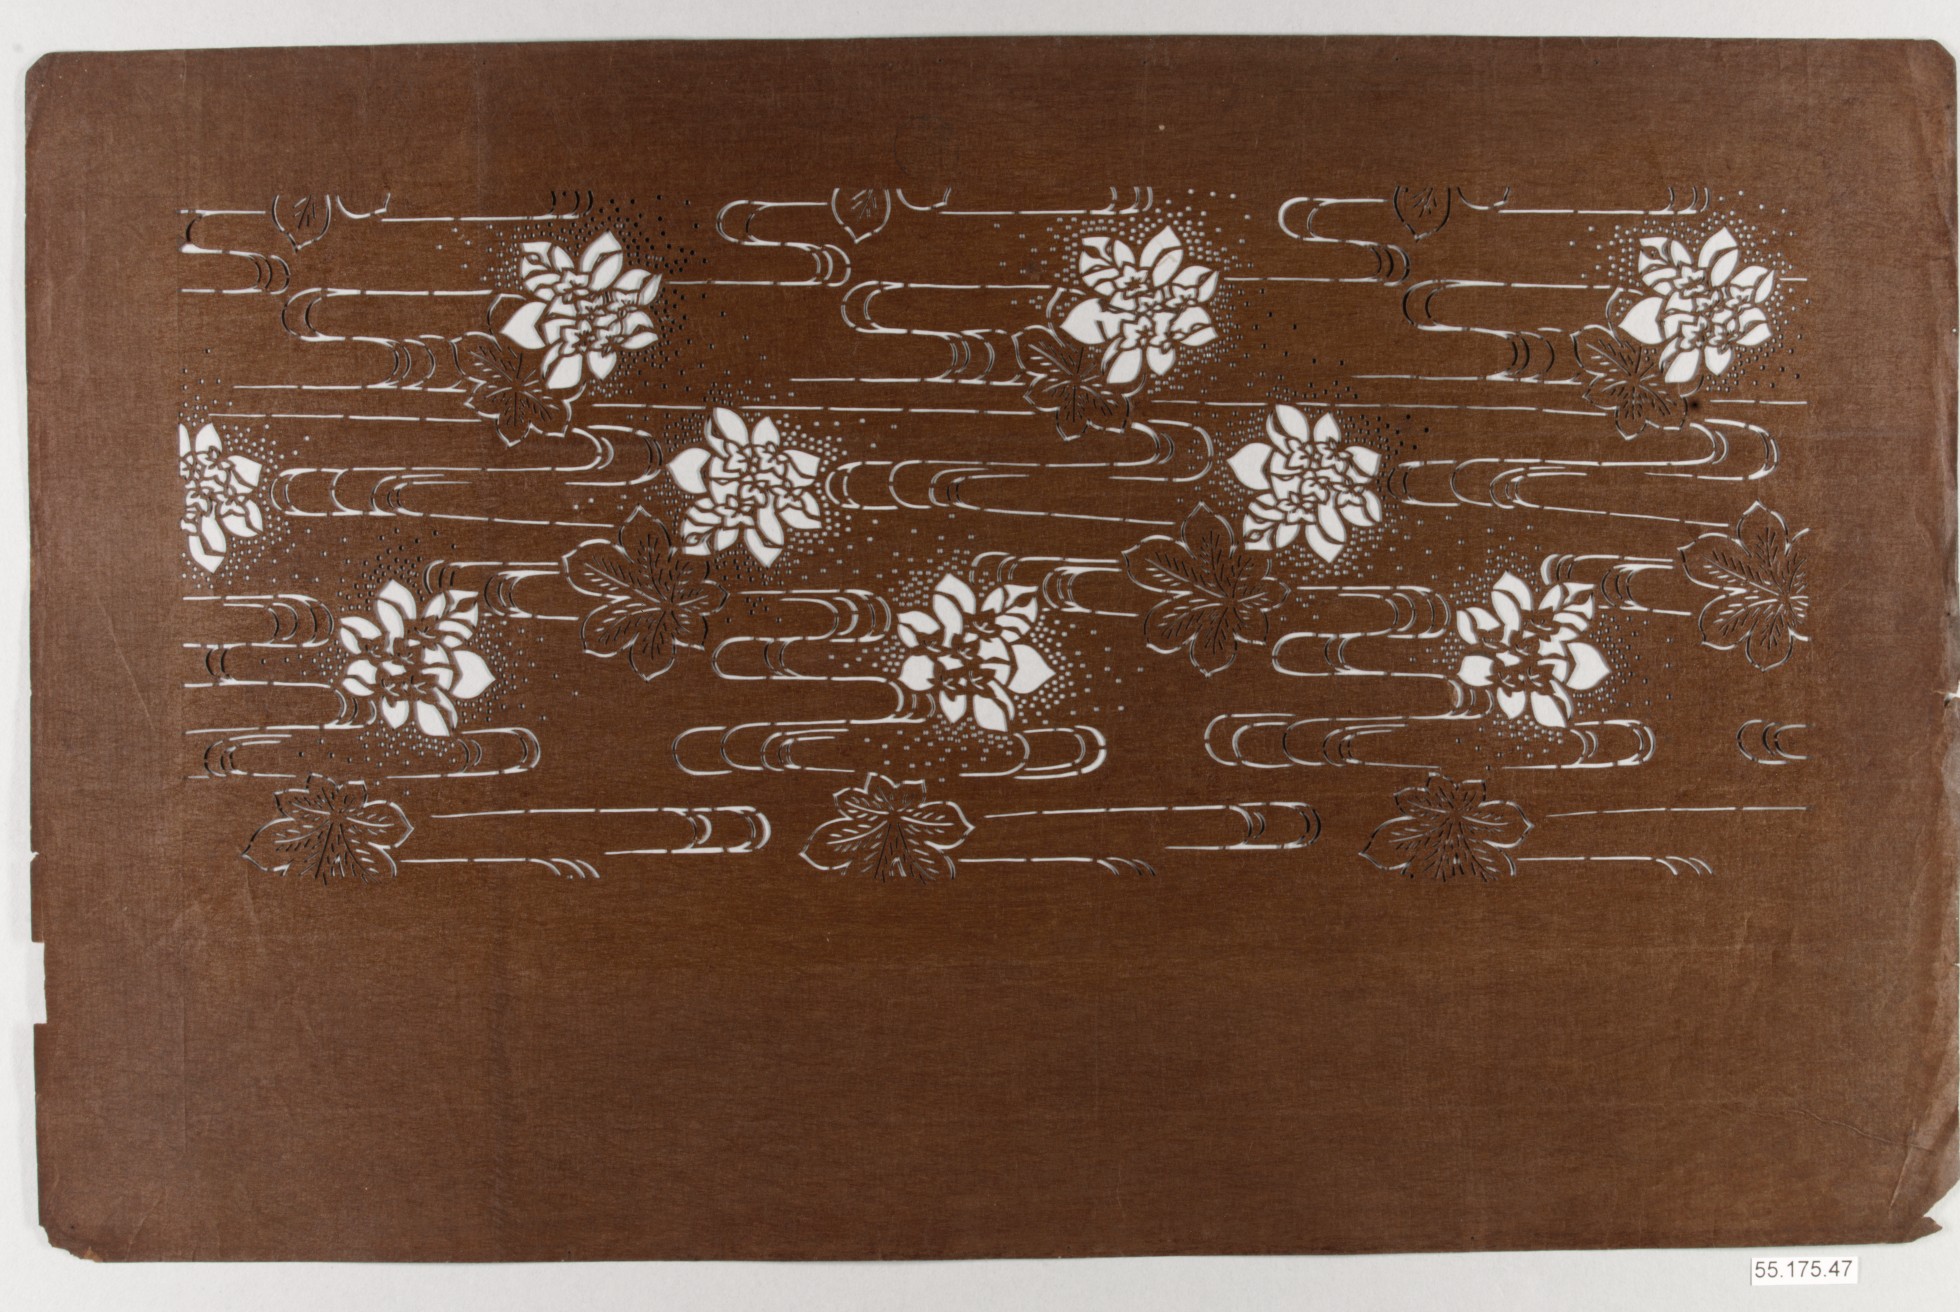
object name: stencil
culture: japanese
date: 1801-1900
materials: paper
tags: flowers